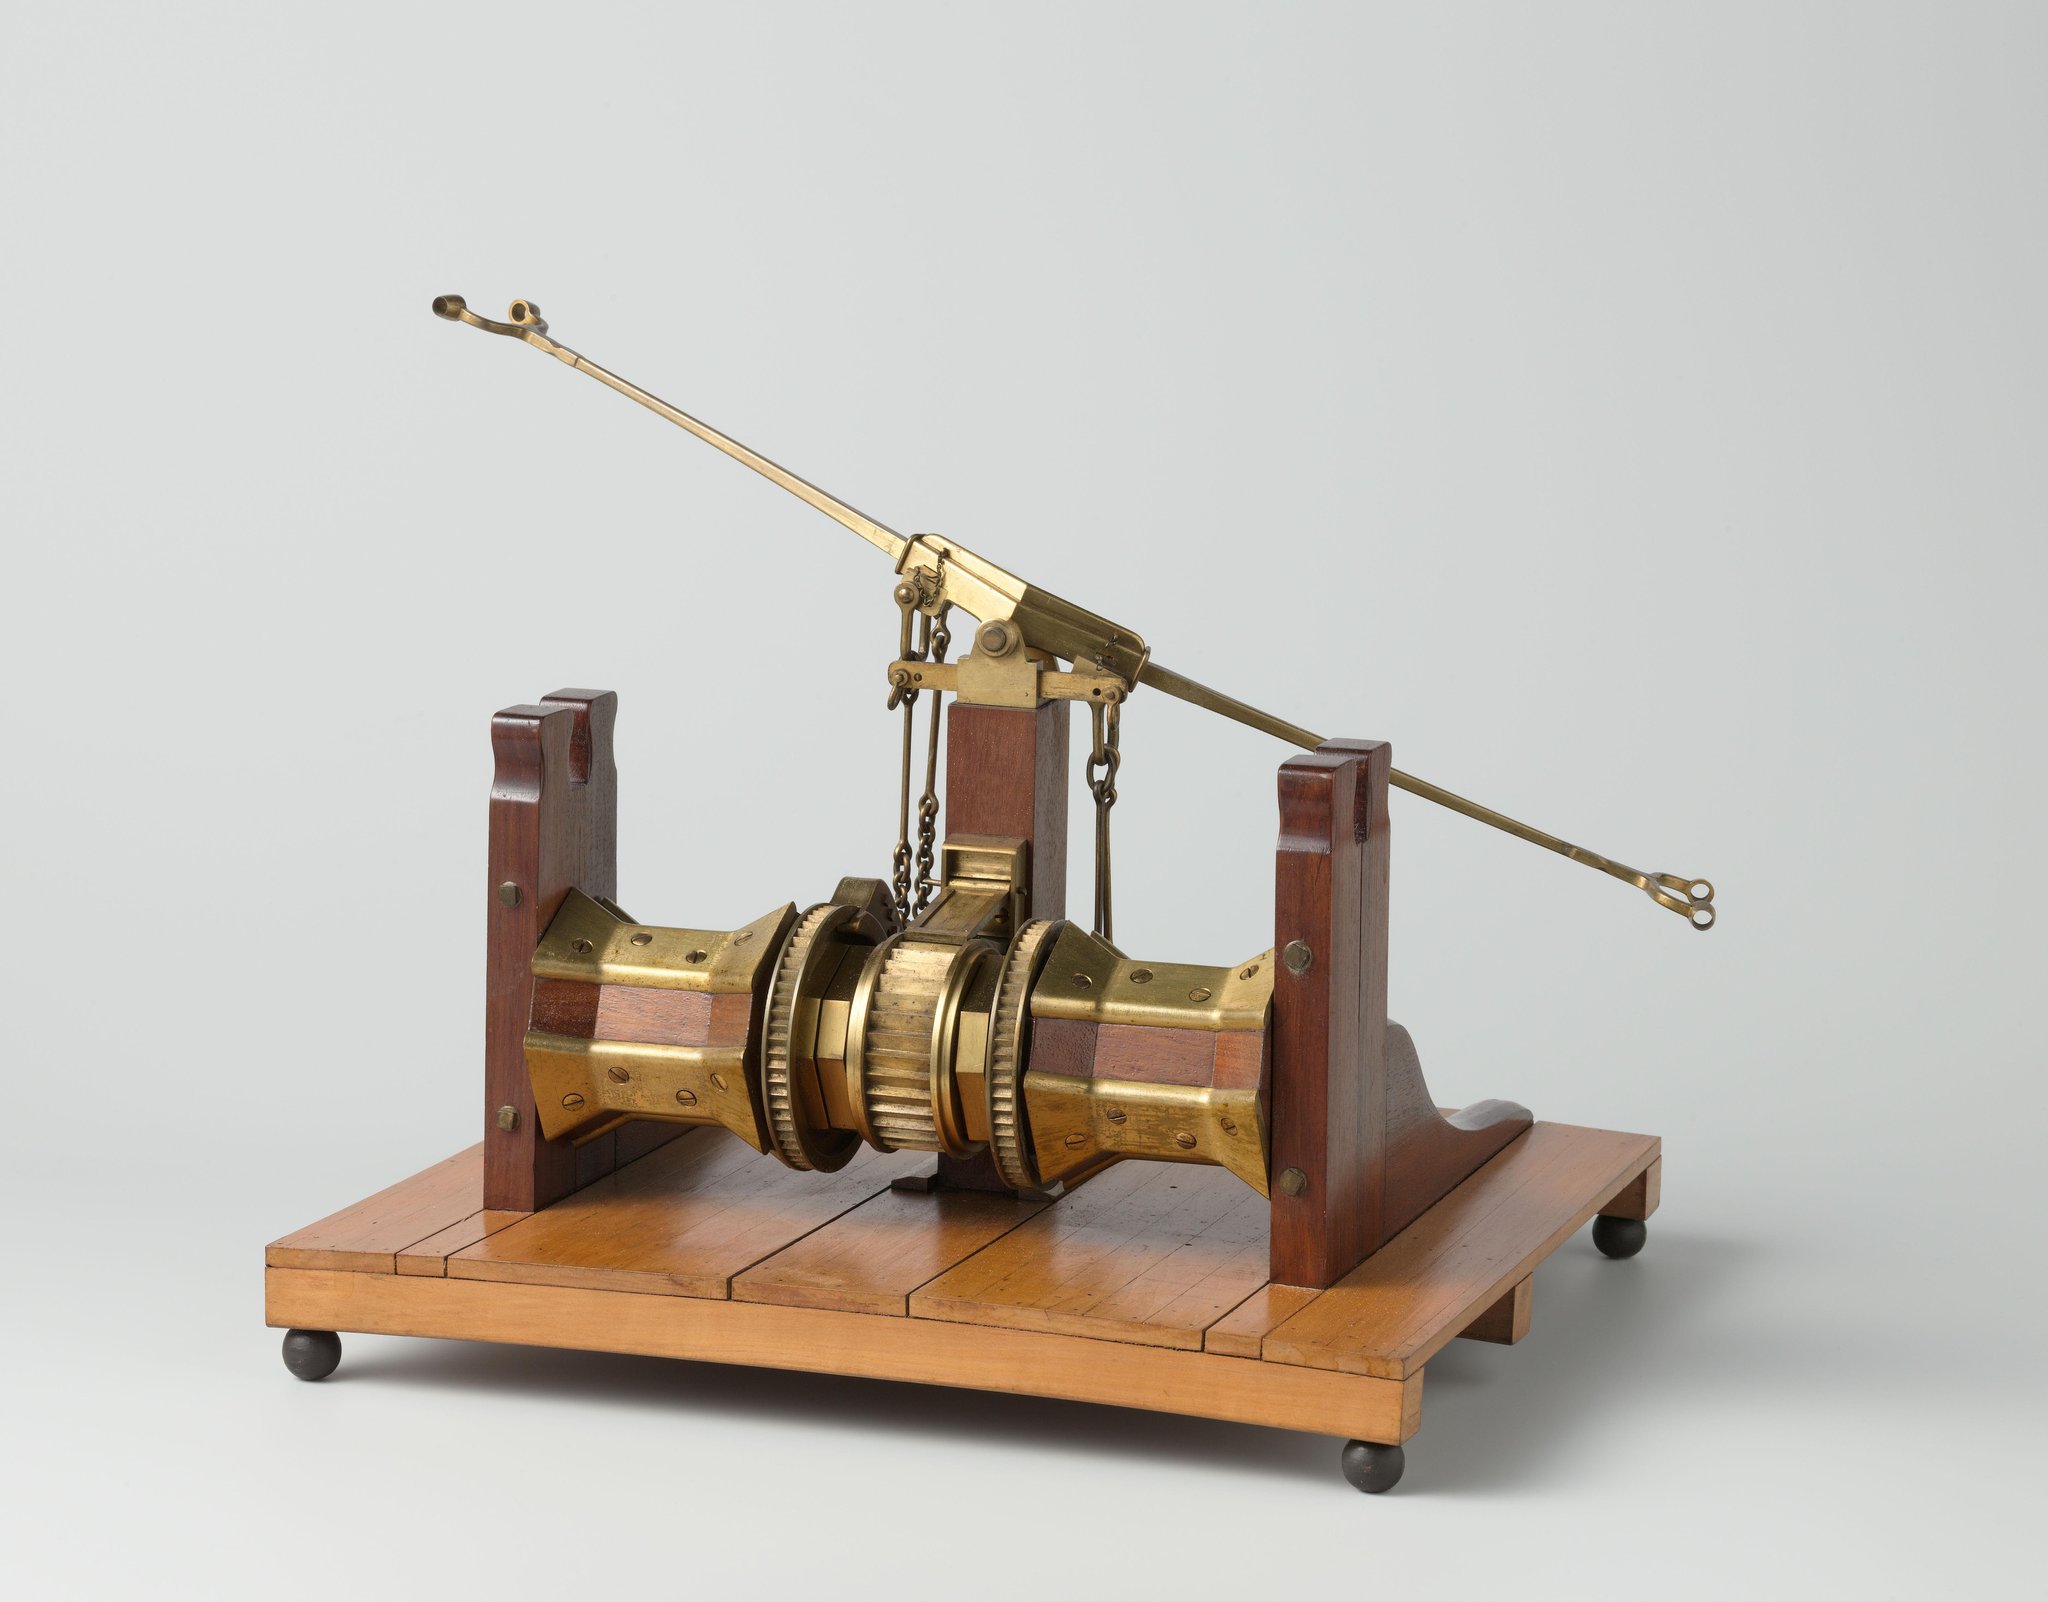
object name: demonstration model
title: Model of a Pump Windlass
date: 1852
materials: brass, wood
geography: leiden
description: Model van een braadspil op een vloerplank. De trommel, opgehangen tussen twee wangen die de braadspilbeting vormen met twee knechten ieder, heeft vier 'Brown'-klampen aan iedere zijde. De braadspil wordt bediend met twee windbomen op een juk op de stut in het midden: rond de trommel lopen tandwielen, waarin pallen grijpen, die ieder aan een zijde van het juk verbonden zijn en die blokkeren bij een opwaartse beweging en vrij zijn als zij vallen. De stut in het midden heeft ook vijf metalen pallen, die in het tandwielgedeelte van de trommel grijpen en teruglopen voorkomen. De wangen kunnen ieder in twee helften uiteengenomen worden. Schaal 1:10 (schatting).